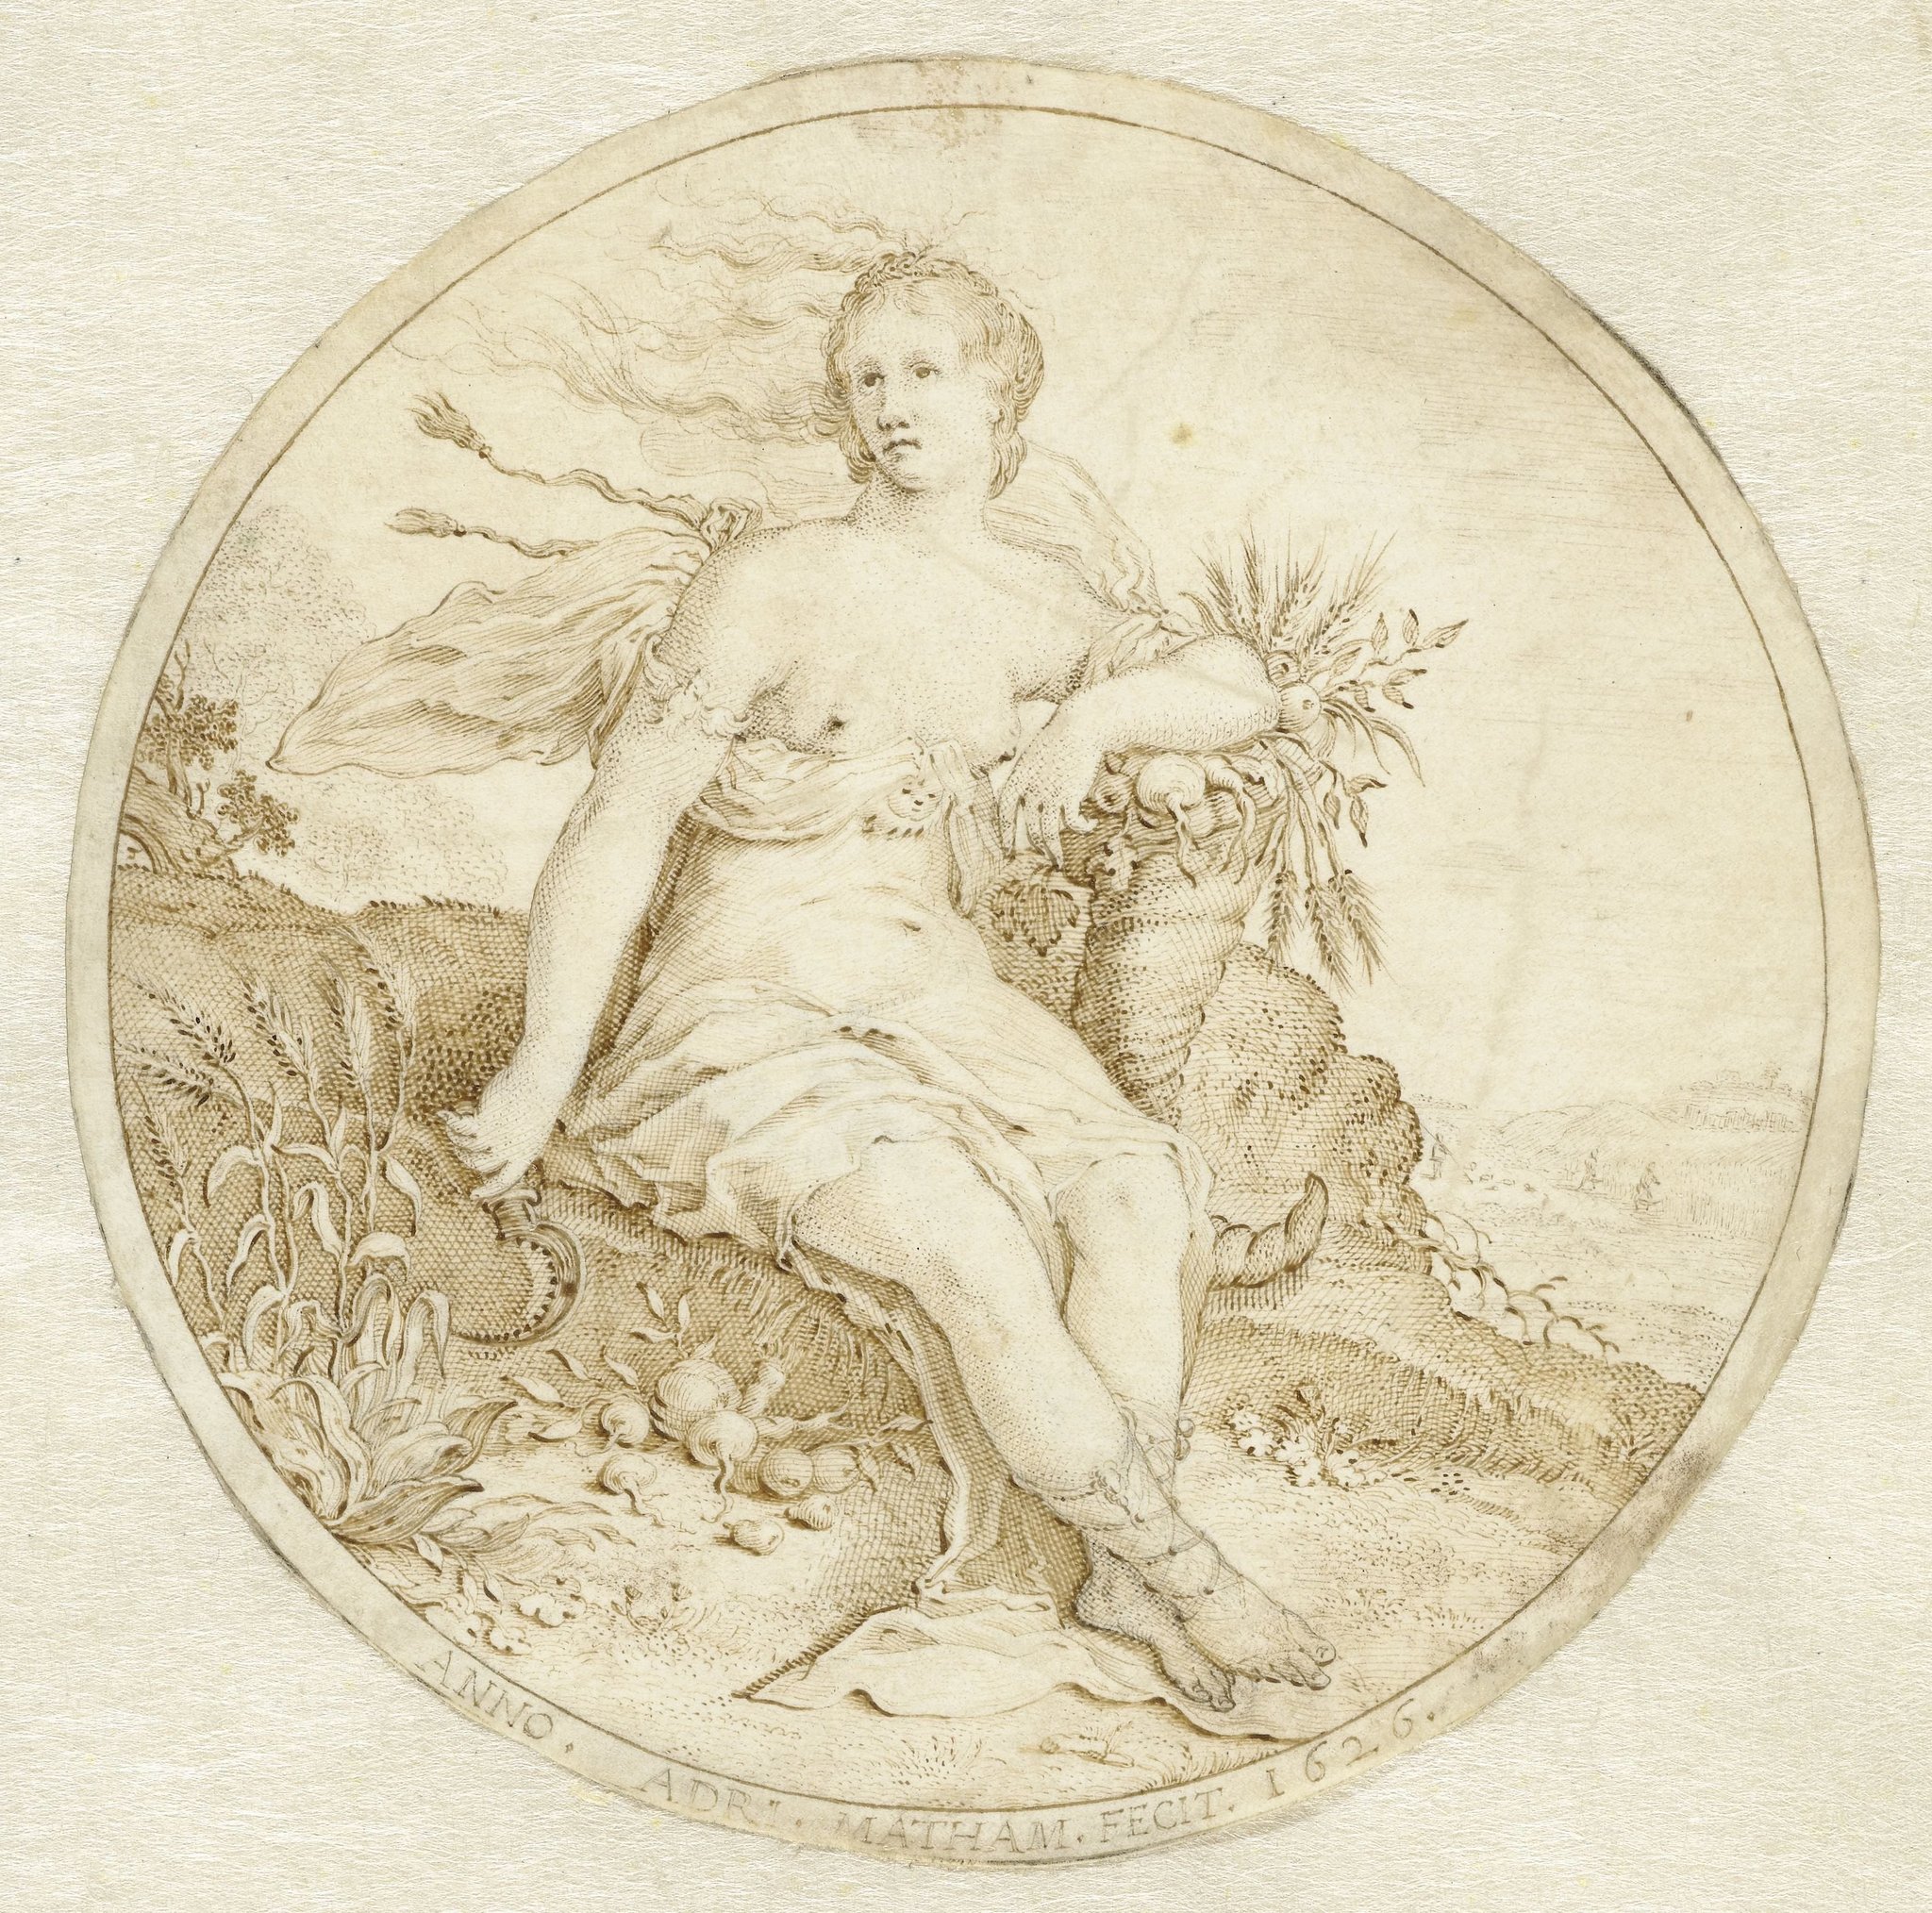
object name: drawing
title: Ceres zittend met een hoorn des overvloeds en een sikkel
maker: adriaen matham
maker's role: draughtsman, print maker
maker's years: 1599-1660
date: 1626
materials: ink, parchment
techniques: pen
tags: (story of) ceres (demeter), 'cornucopia', horn of plenty, attributes of ceres: sickle